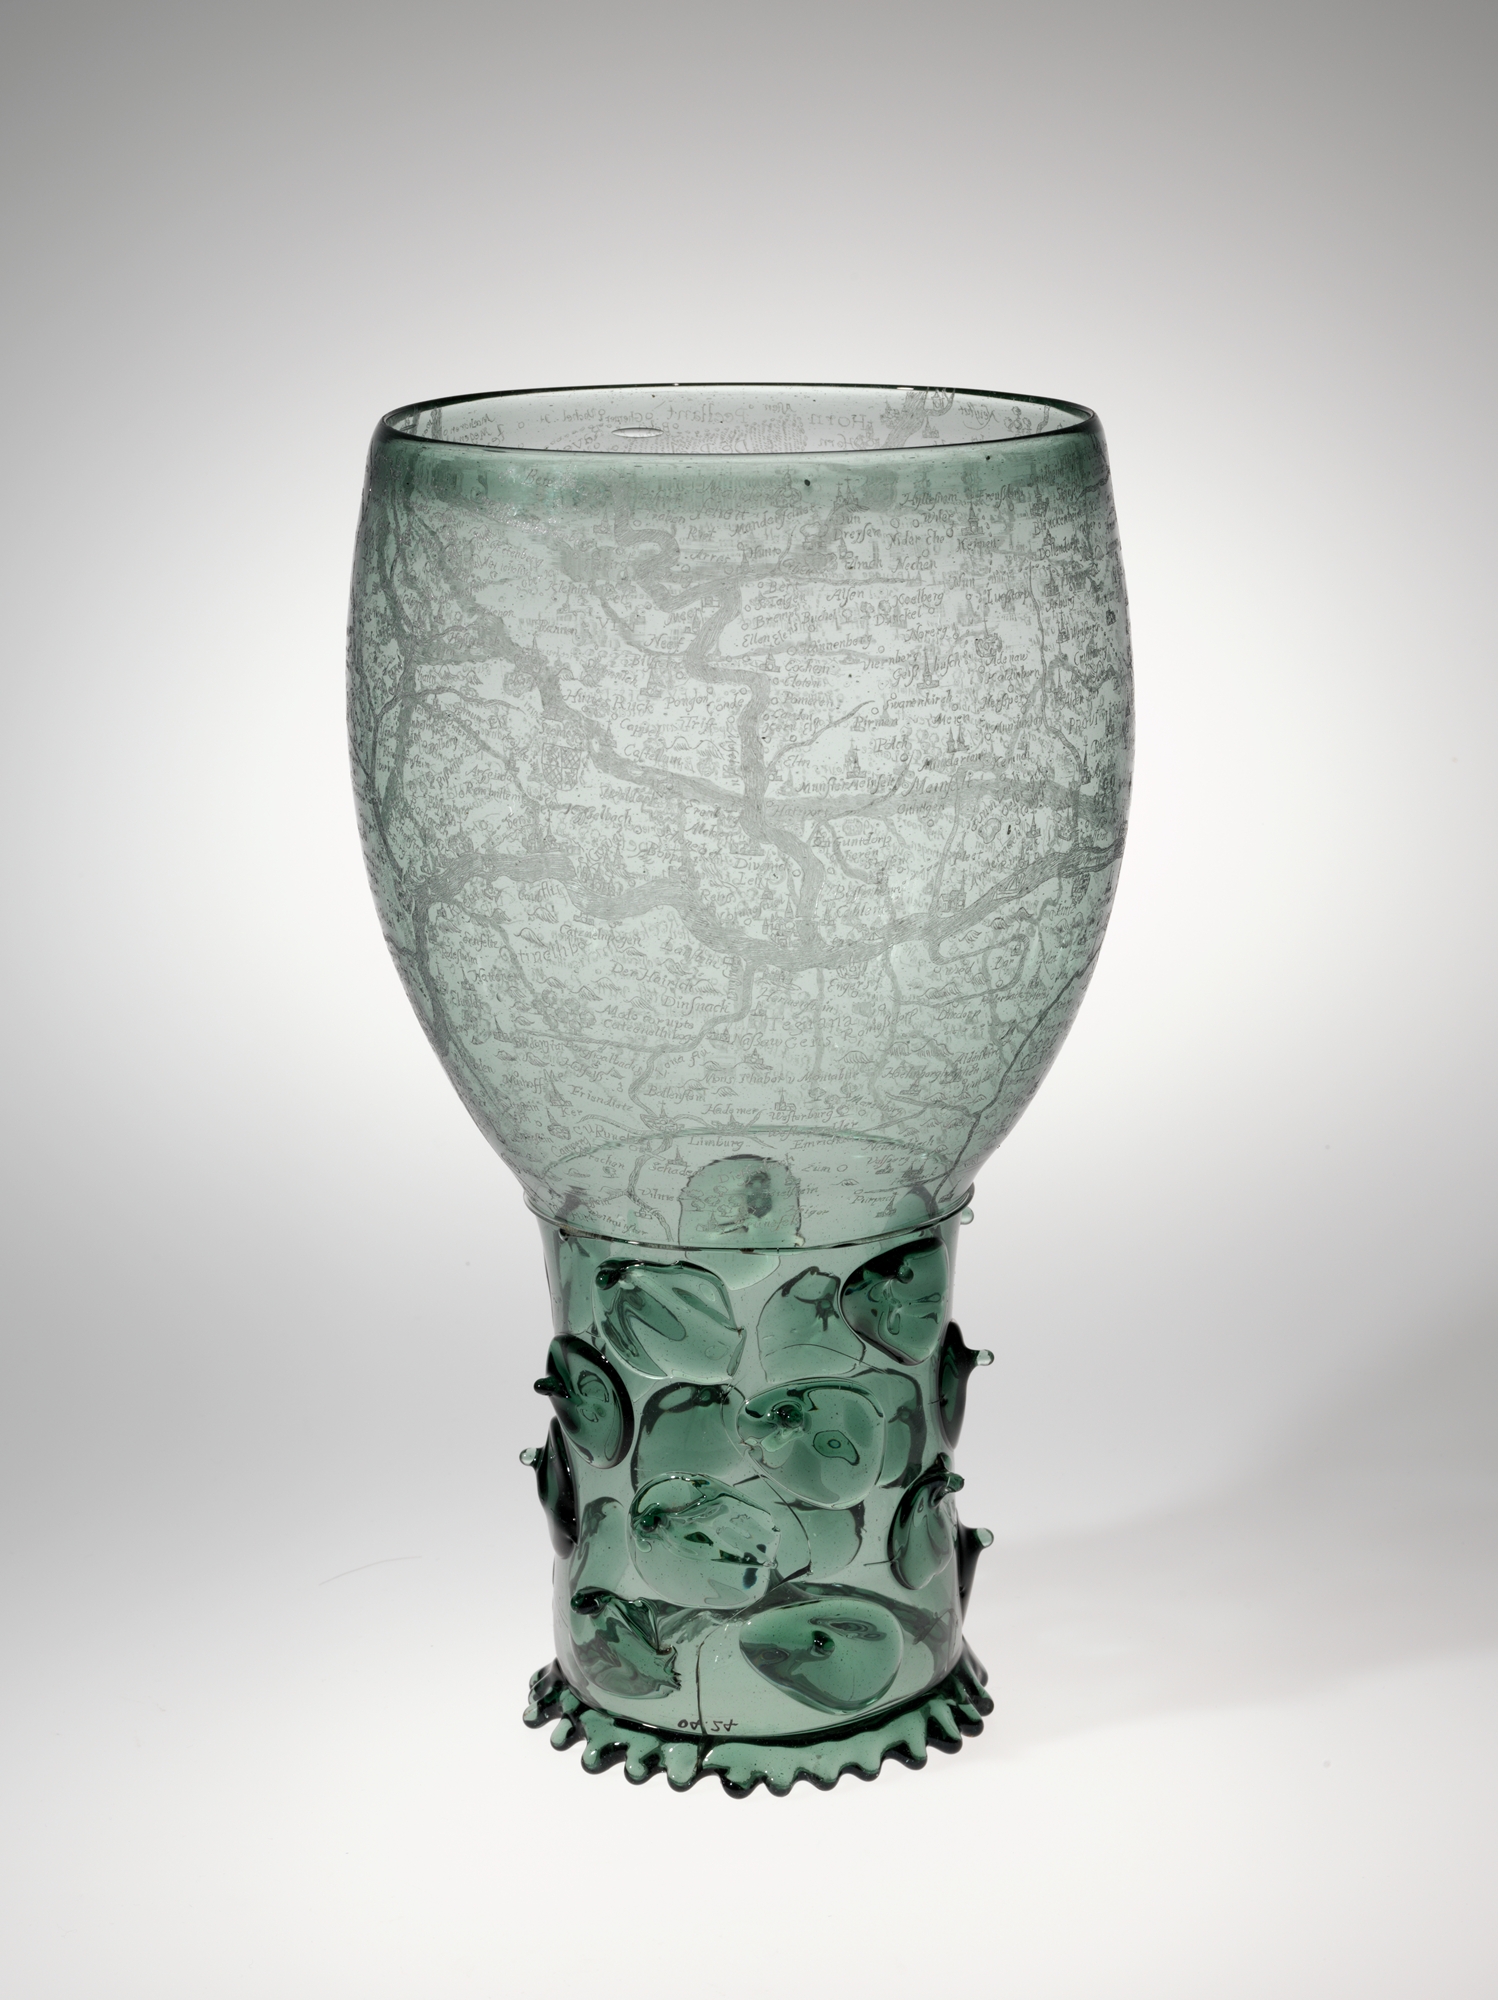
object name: goblet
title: Goblet (Roemer) with map of the Rhine River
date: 1601-1633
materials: diamond, glass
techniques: engraving